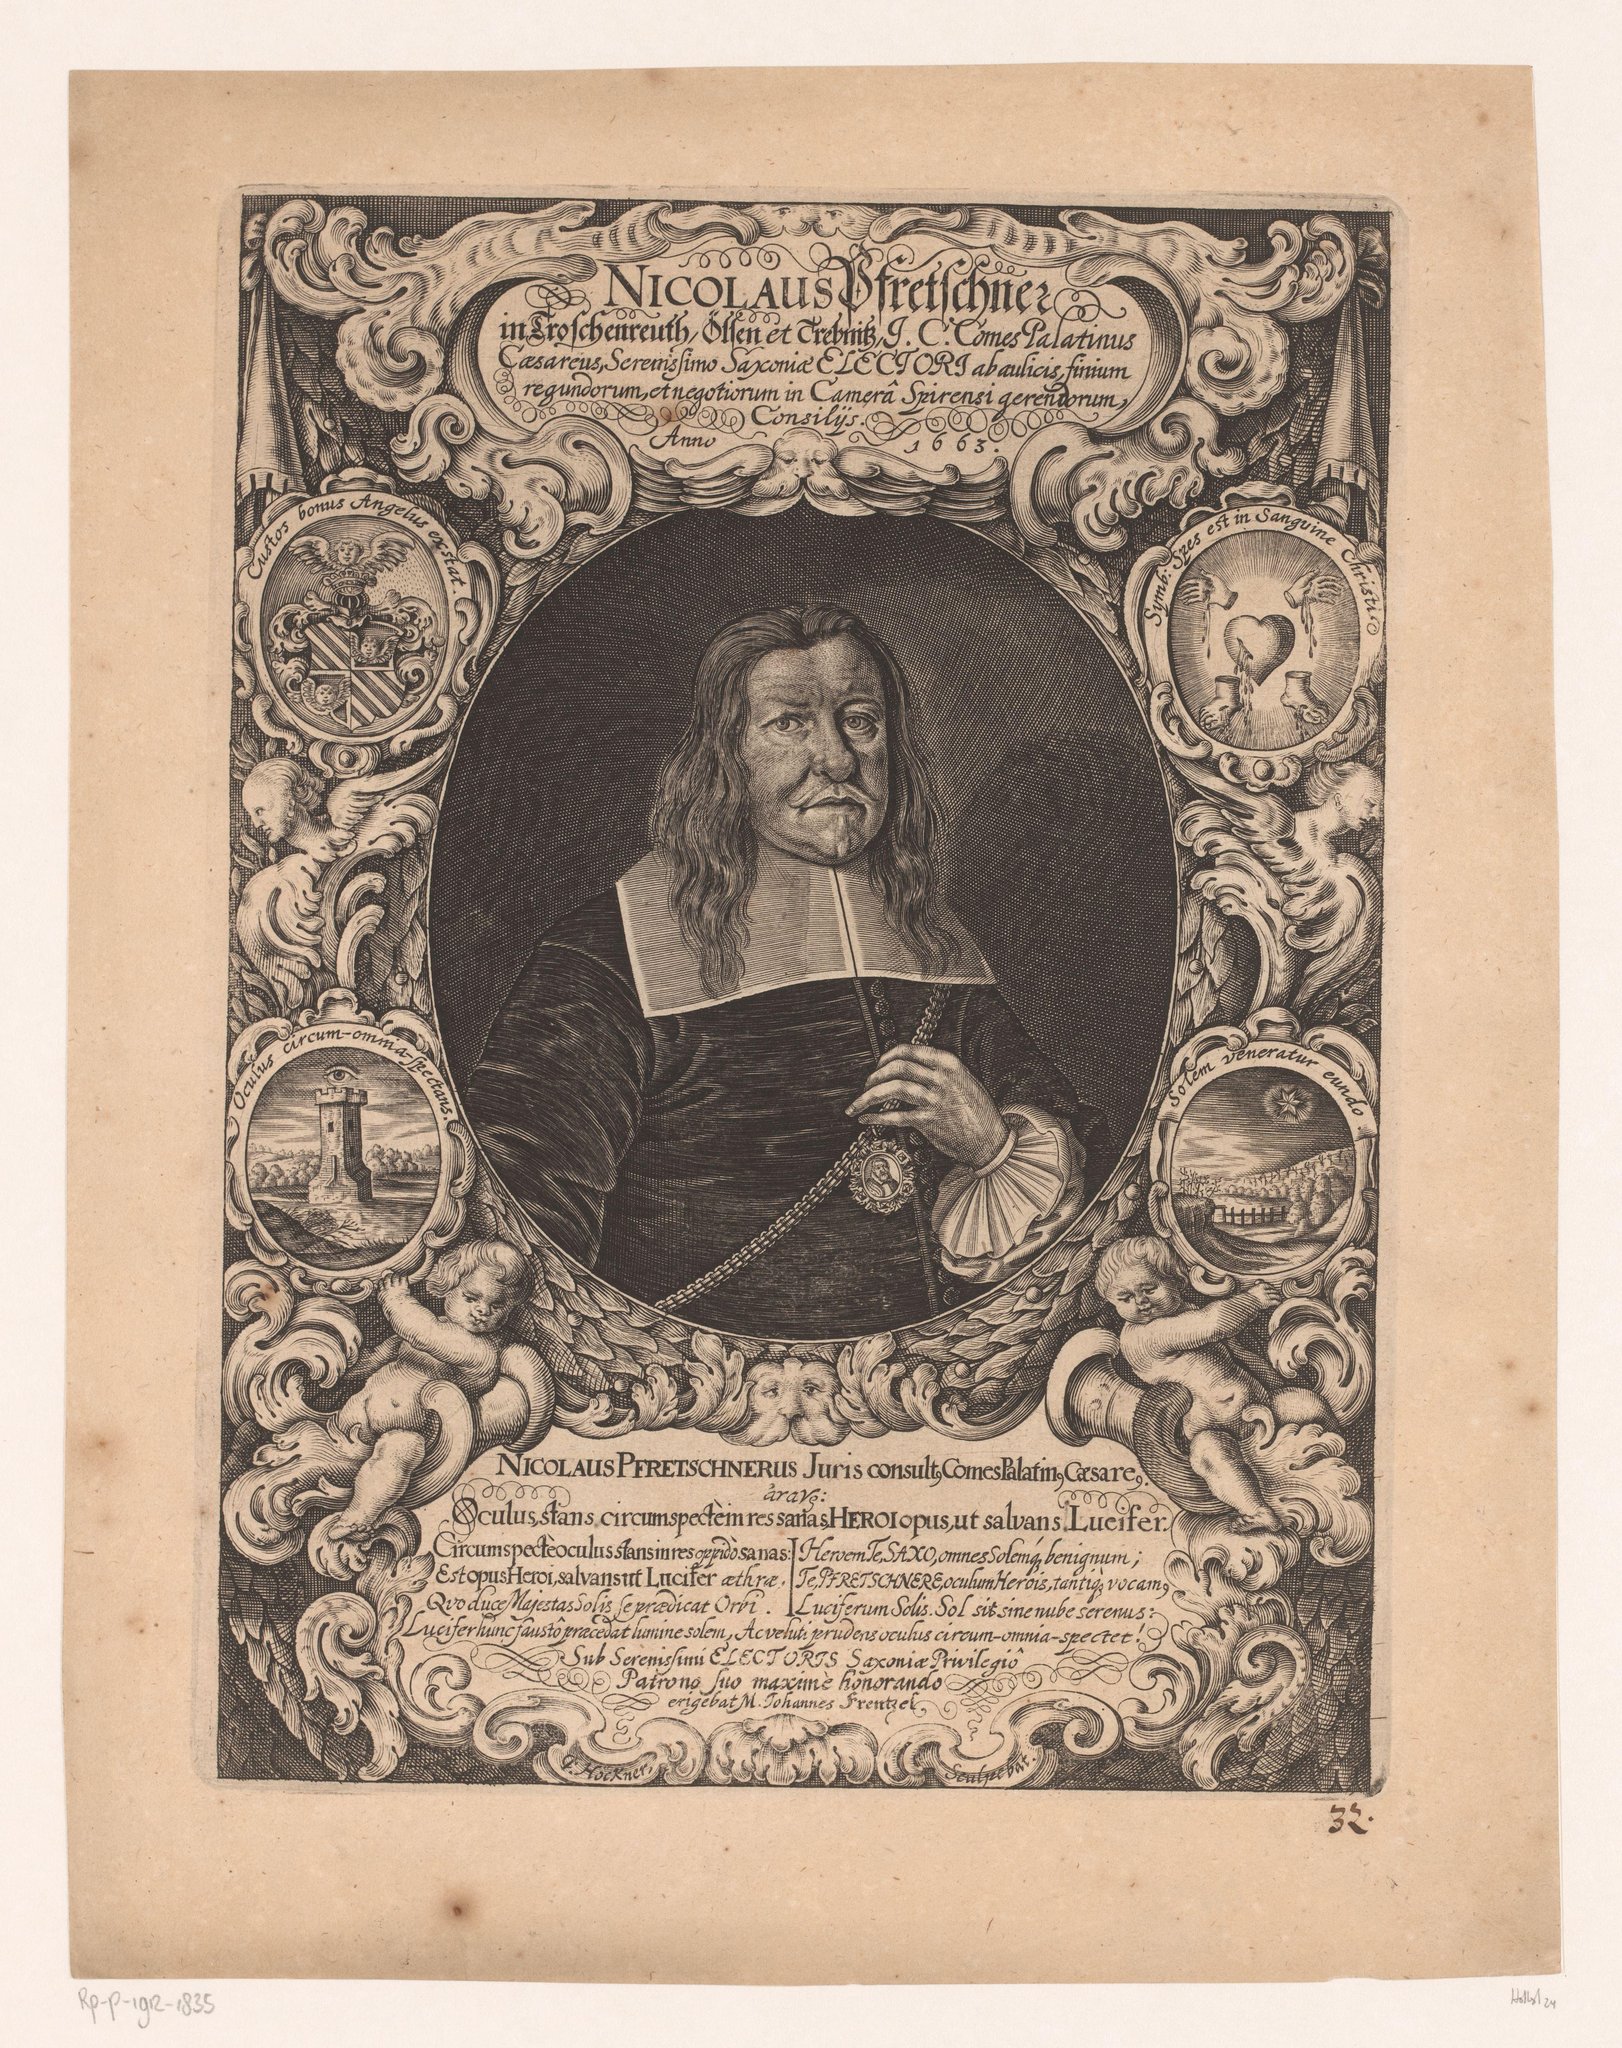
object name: titelblad, titelpagina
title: Titelpagina voor: Justus Siebers, poetisierende Jugend oder allerhand geist- und weltliche teutsche Gedichte, 1658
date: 1658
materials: paper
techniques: engraving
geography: dresden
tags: trees: laurel (branch, stick), herding, herdsman, herdswoman, shepherd, shepherdess, cowherd, etc., foliated head ~ ornament, historical persons, trees: laurel, sun represented as face, wheel, etc., ornament ~ cartouche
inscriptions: collector's mark: Lugt 2228